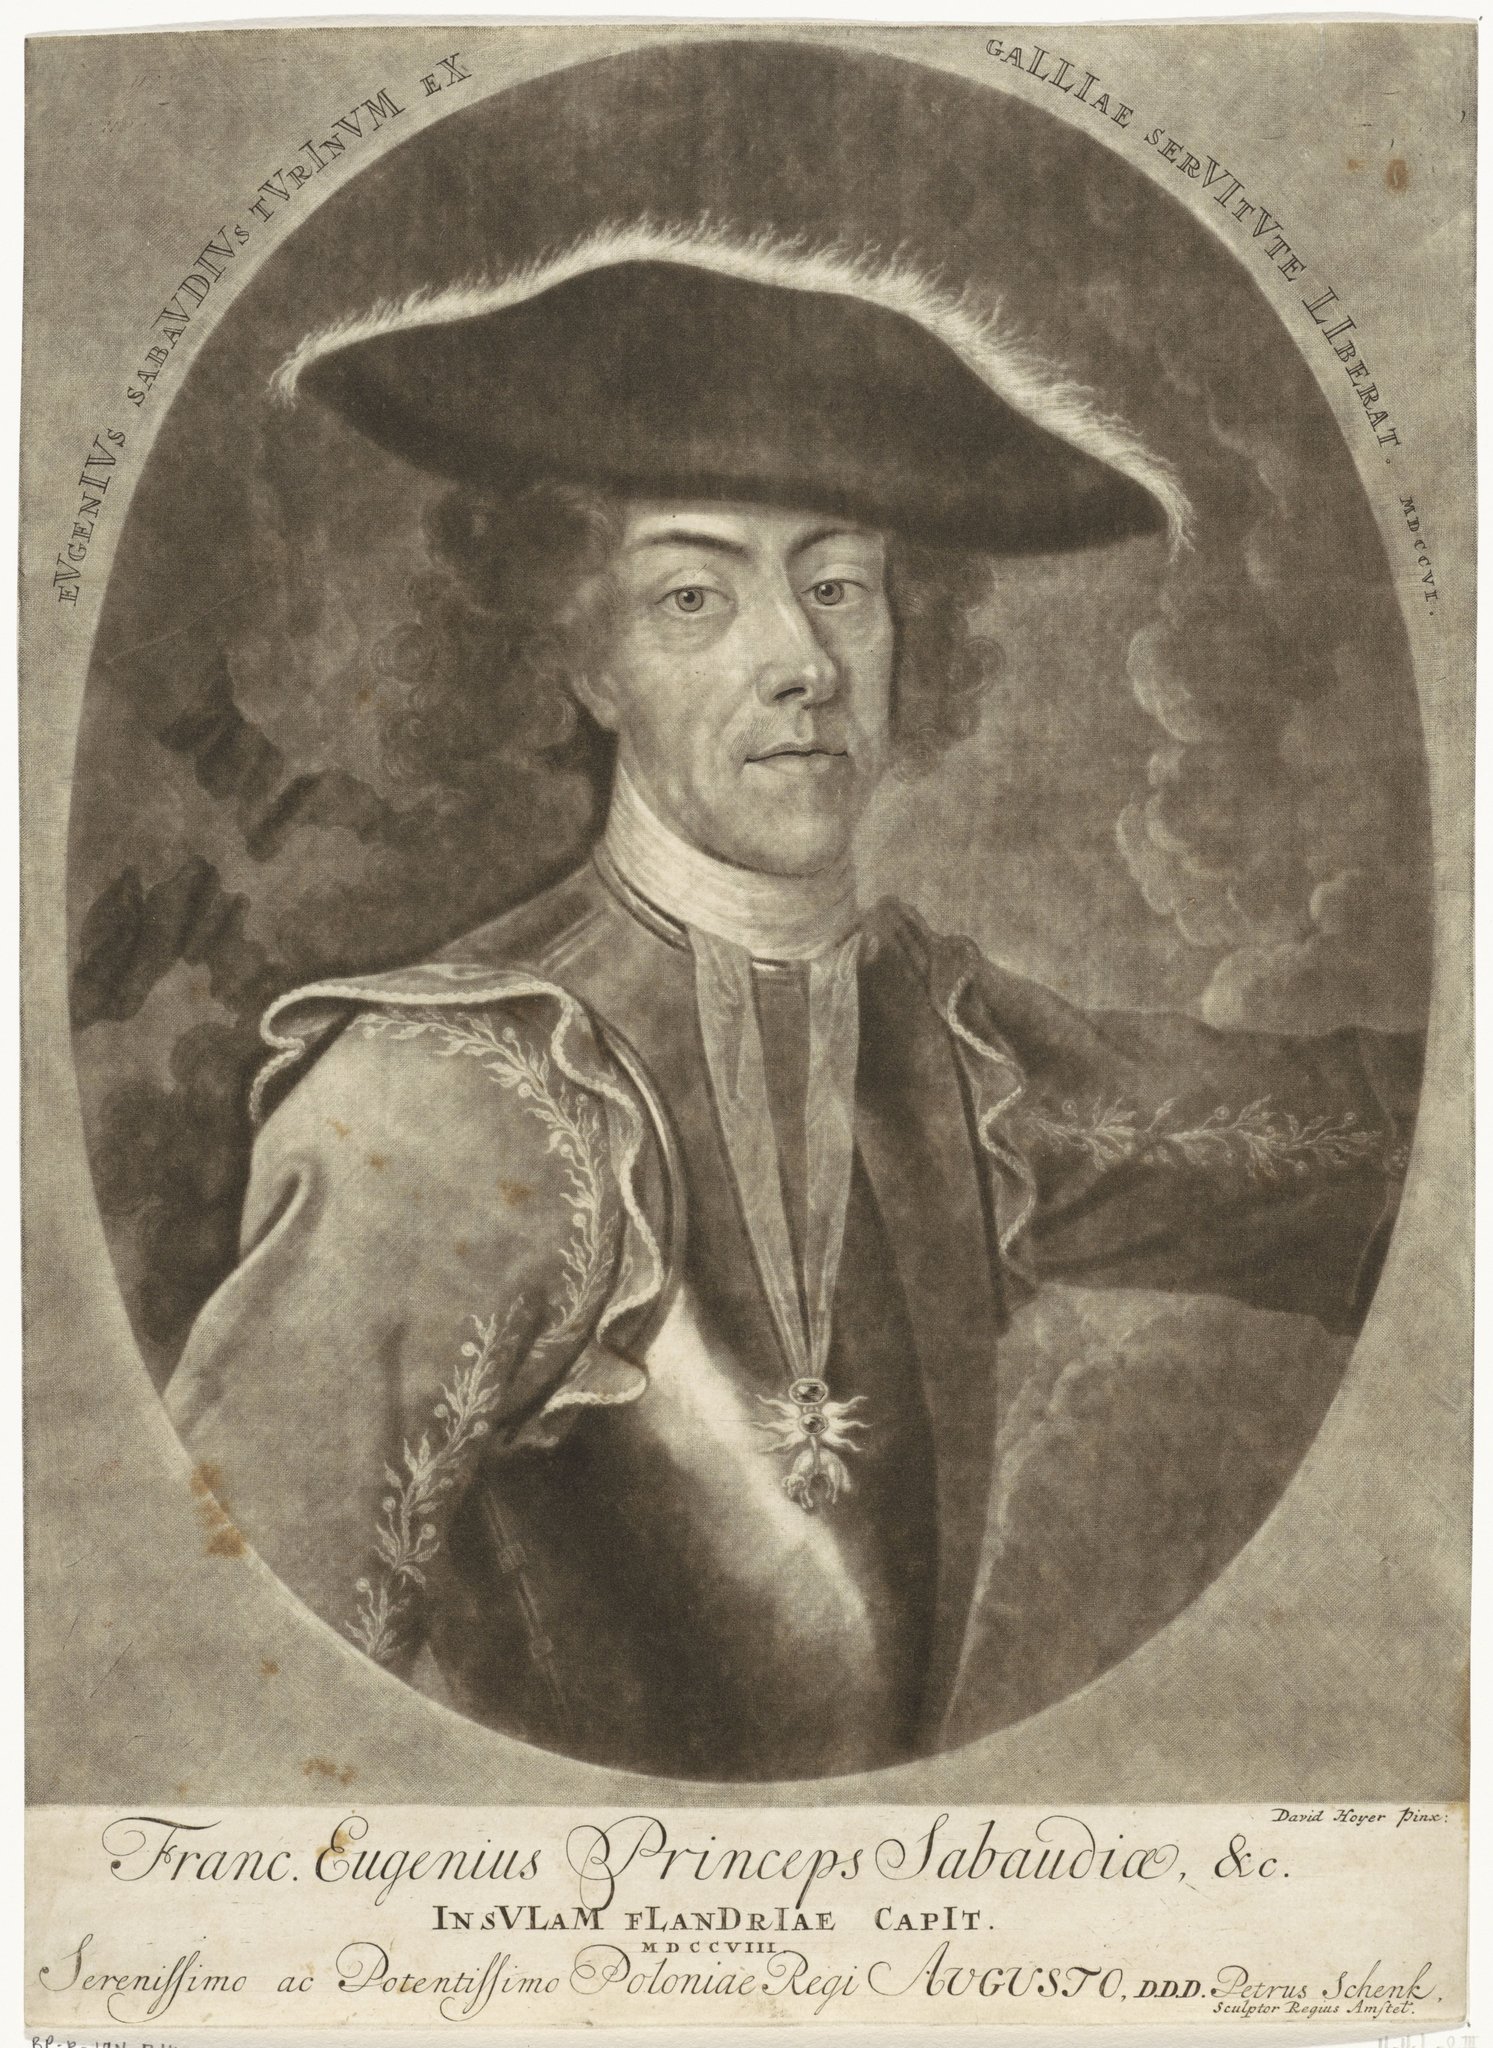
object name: print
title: Portret van Eugenius van Savoye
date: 1706-1713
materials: paper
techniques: engraving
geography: amsterdam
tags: paris, vienna, eugenius van savoye, knighthood order of the golden fleece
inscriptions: collector's mark: Lugt 2228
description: Eugenius, prins van Savoye en generaal van Oostenrijk. Om zijn hals een lint met het teken van de Orde van het Gulden Vlies.